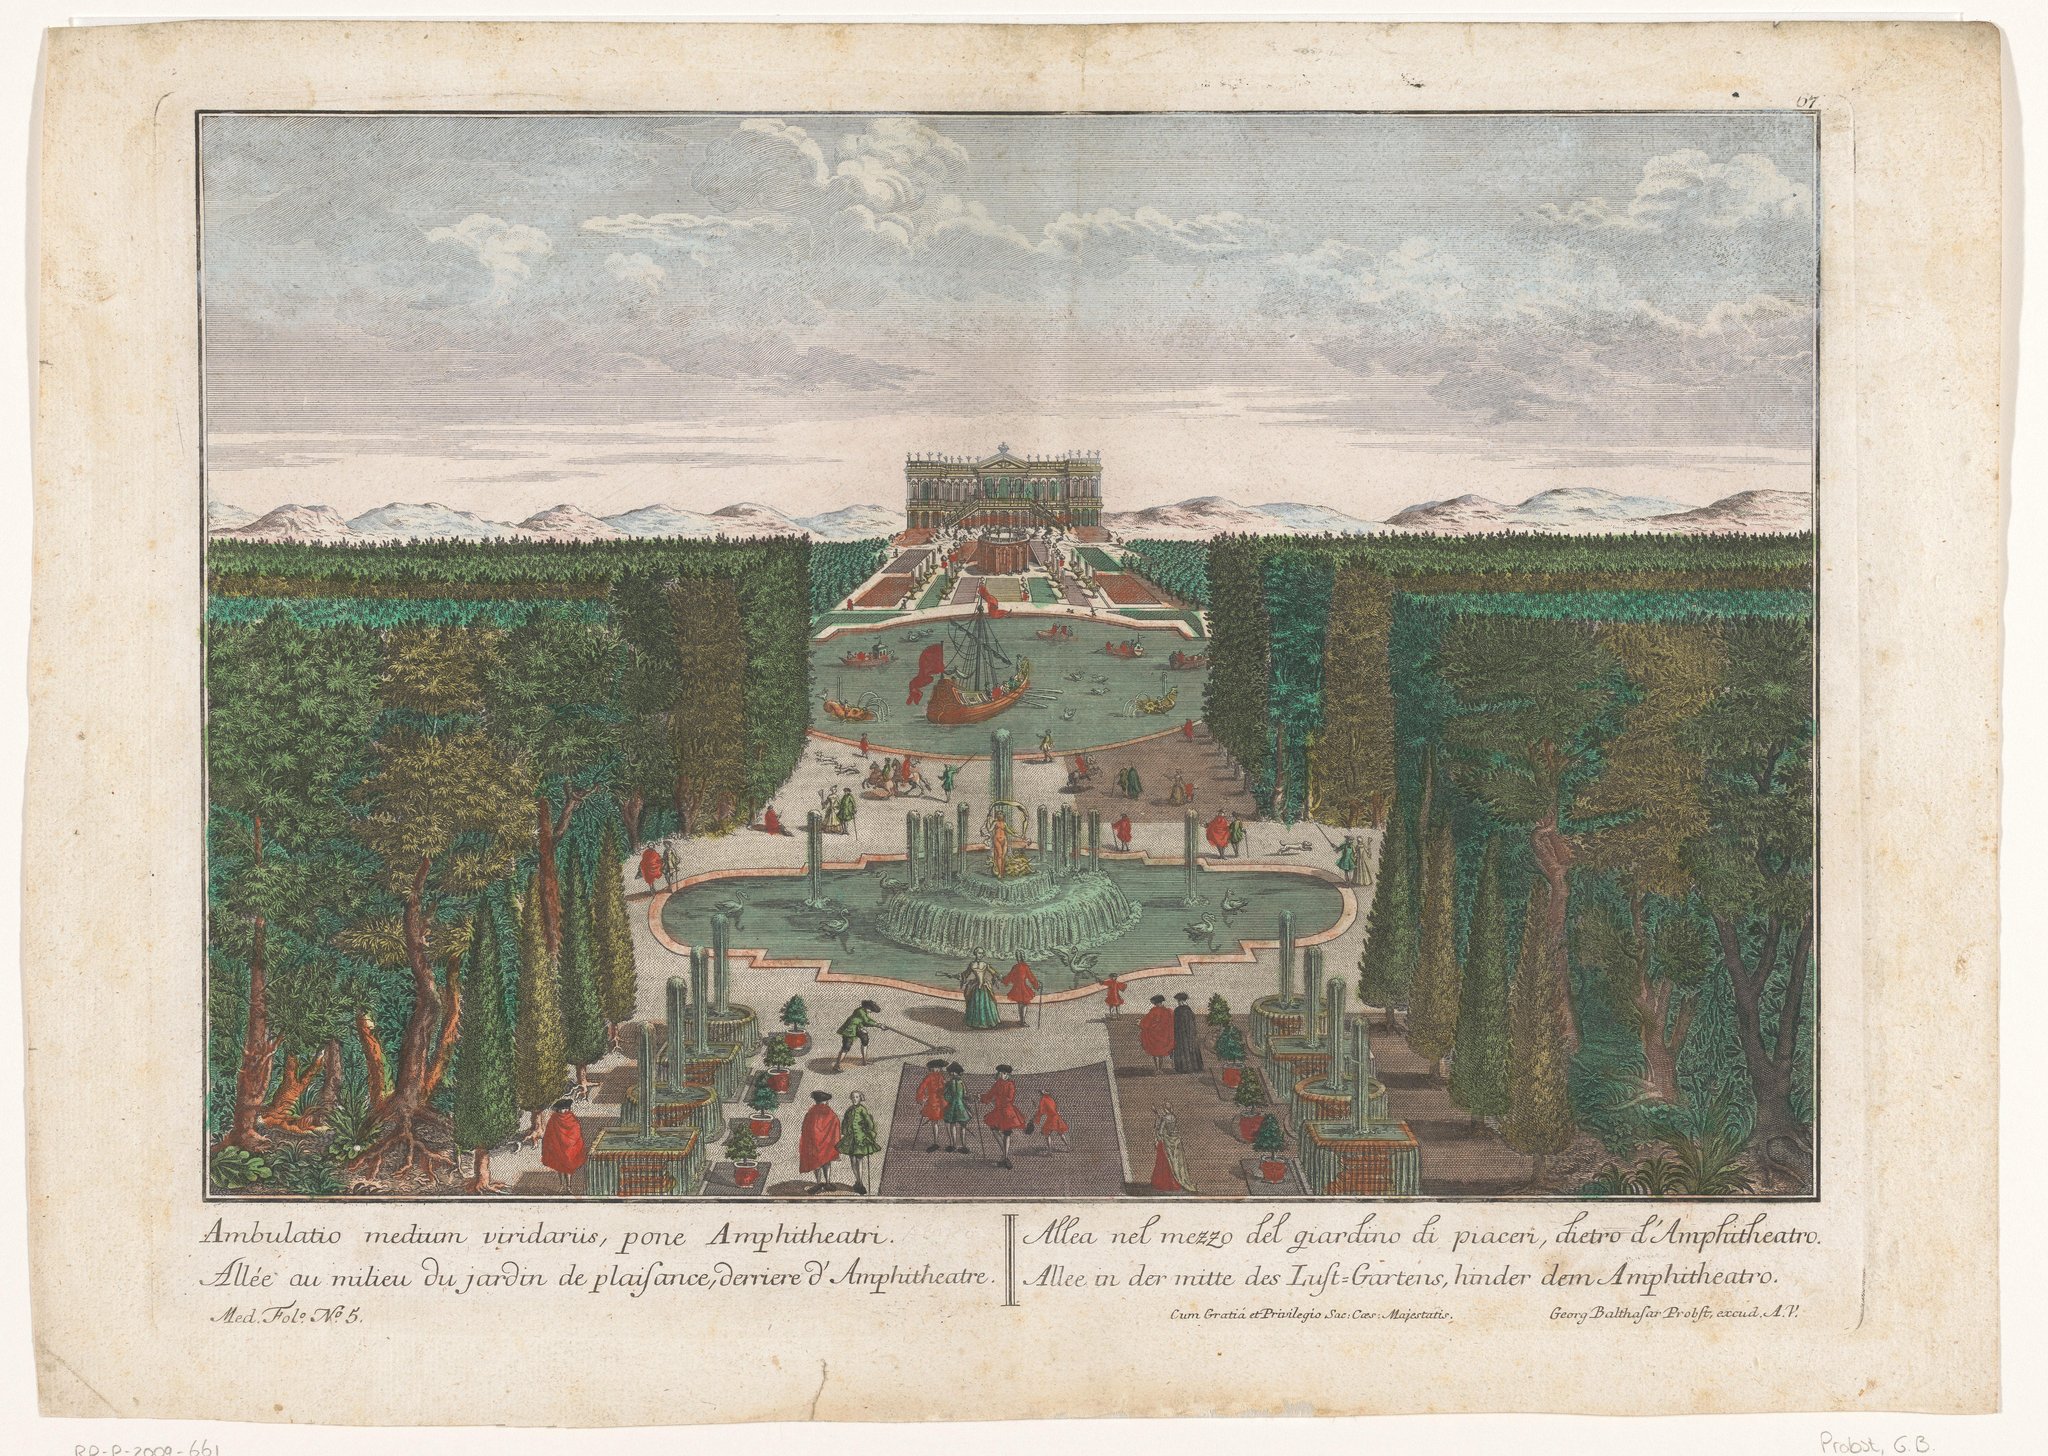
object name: opticaprent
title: Allee in der Mitte des Lust Gartens, hinder dem Amphitheatro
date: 1742-1801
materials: paper, watercolor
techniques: brush, etching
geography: augsburg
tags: garden, garden fountain, ornamental plants, garden ornaments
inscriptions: collector's mark: Lugt 2228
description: Vogelvluchtgezicht tuinen met veel fonteinen en een grote vijver waarop een groot schip vaart, omgeven door hoge heggen waarachter bossen. Onder de afbeelding de titel in vier talen.